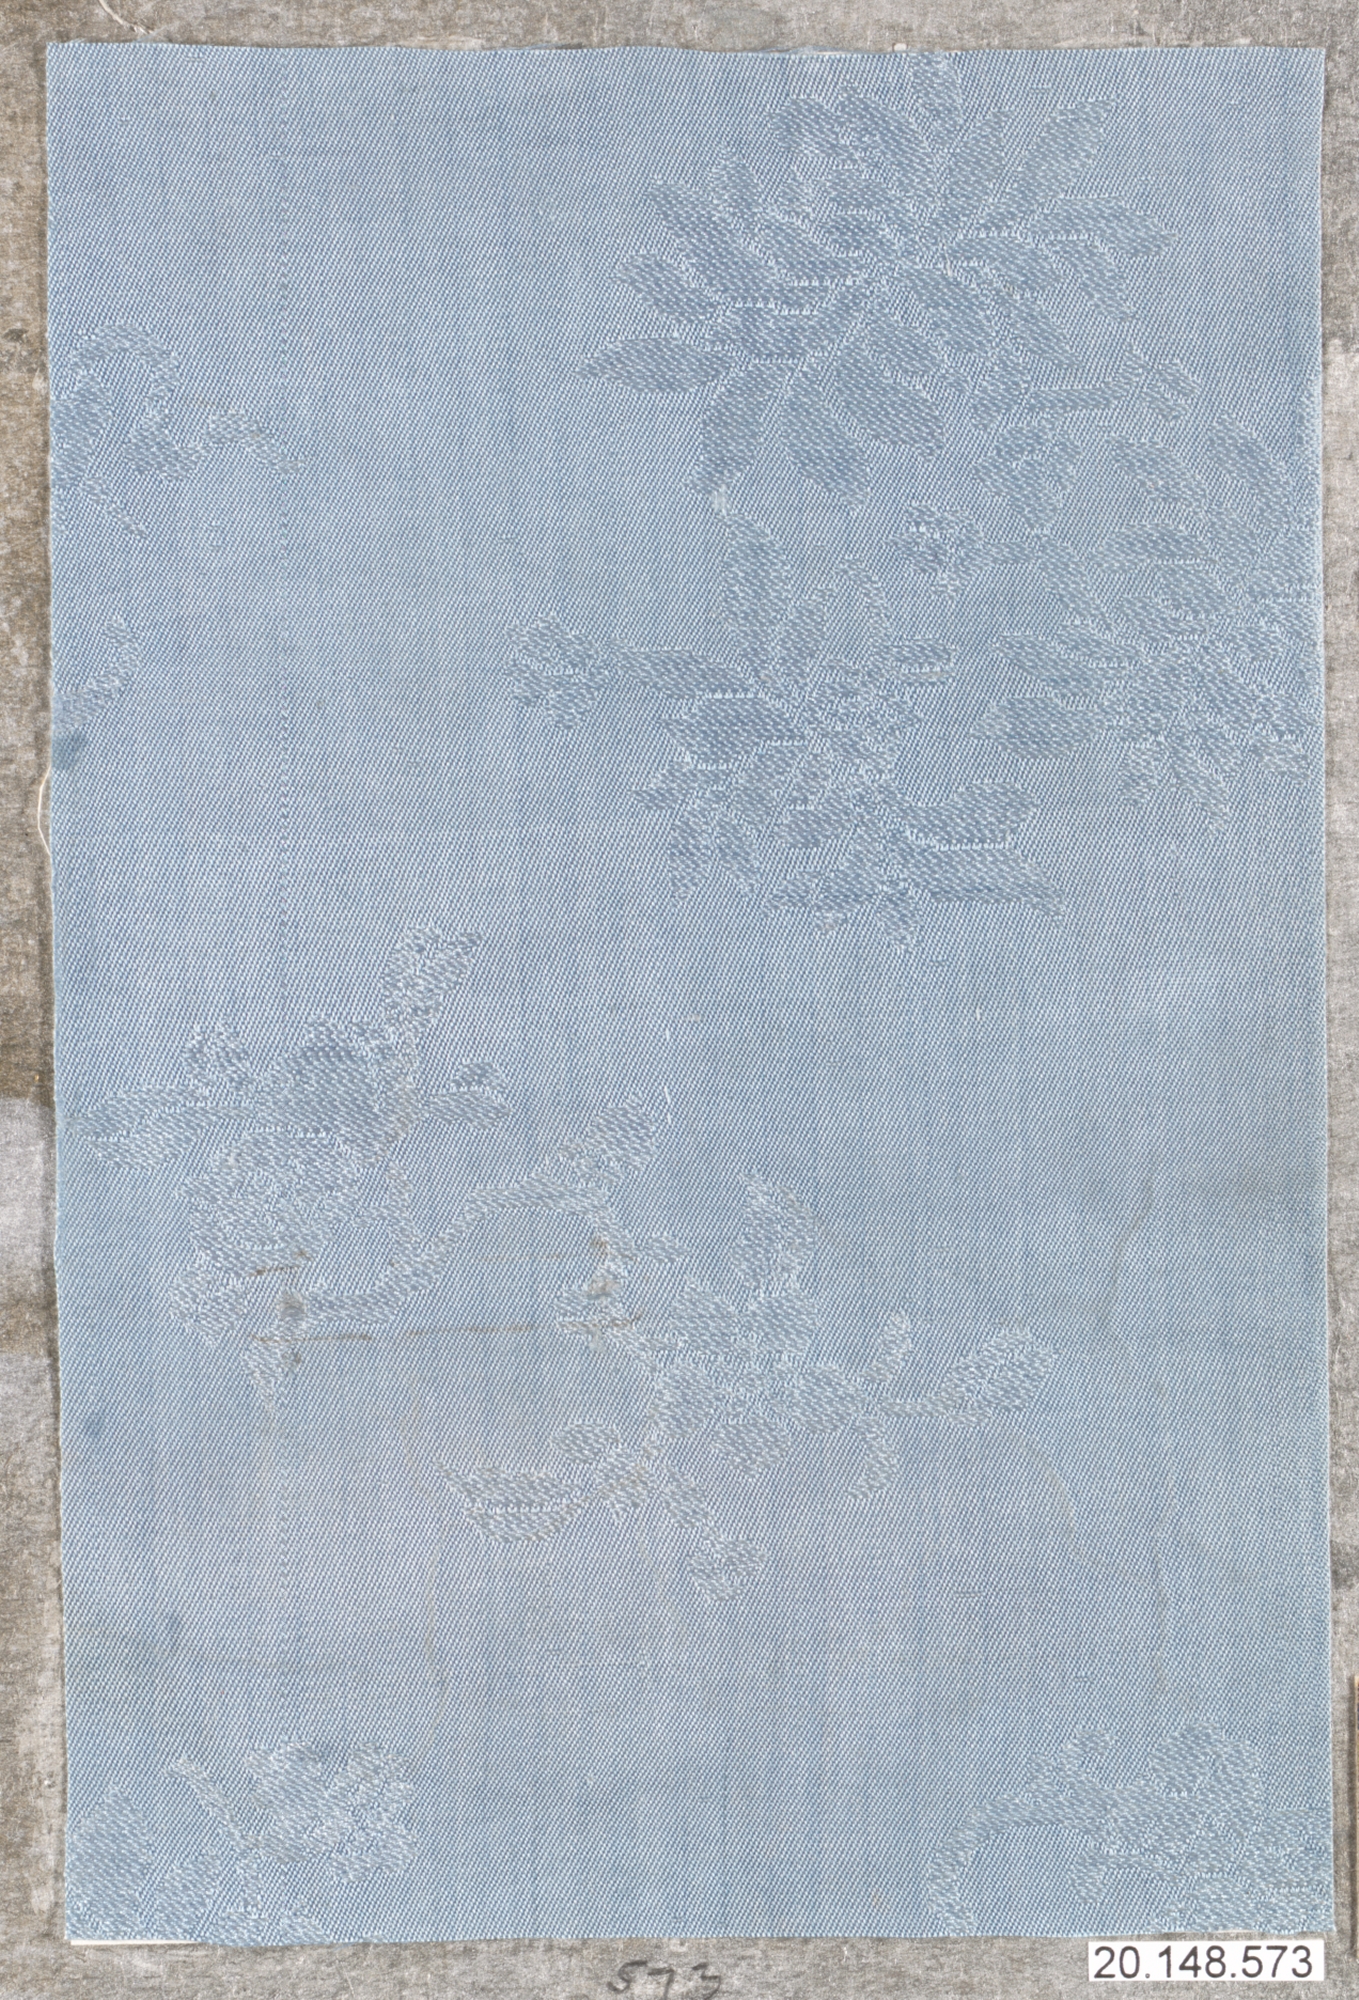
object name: piece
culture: japanese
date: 1701-1800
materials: silk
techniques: compound weave